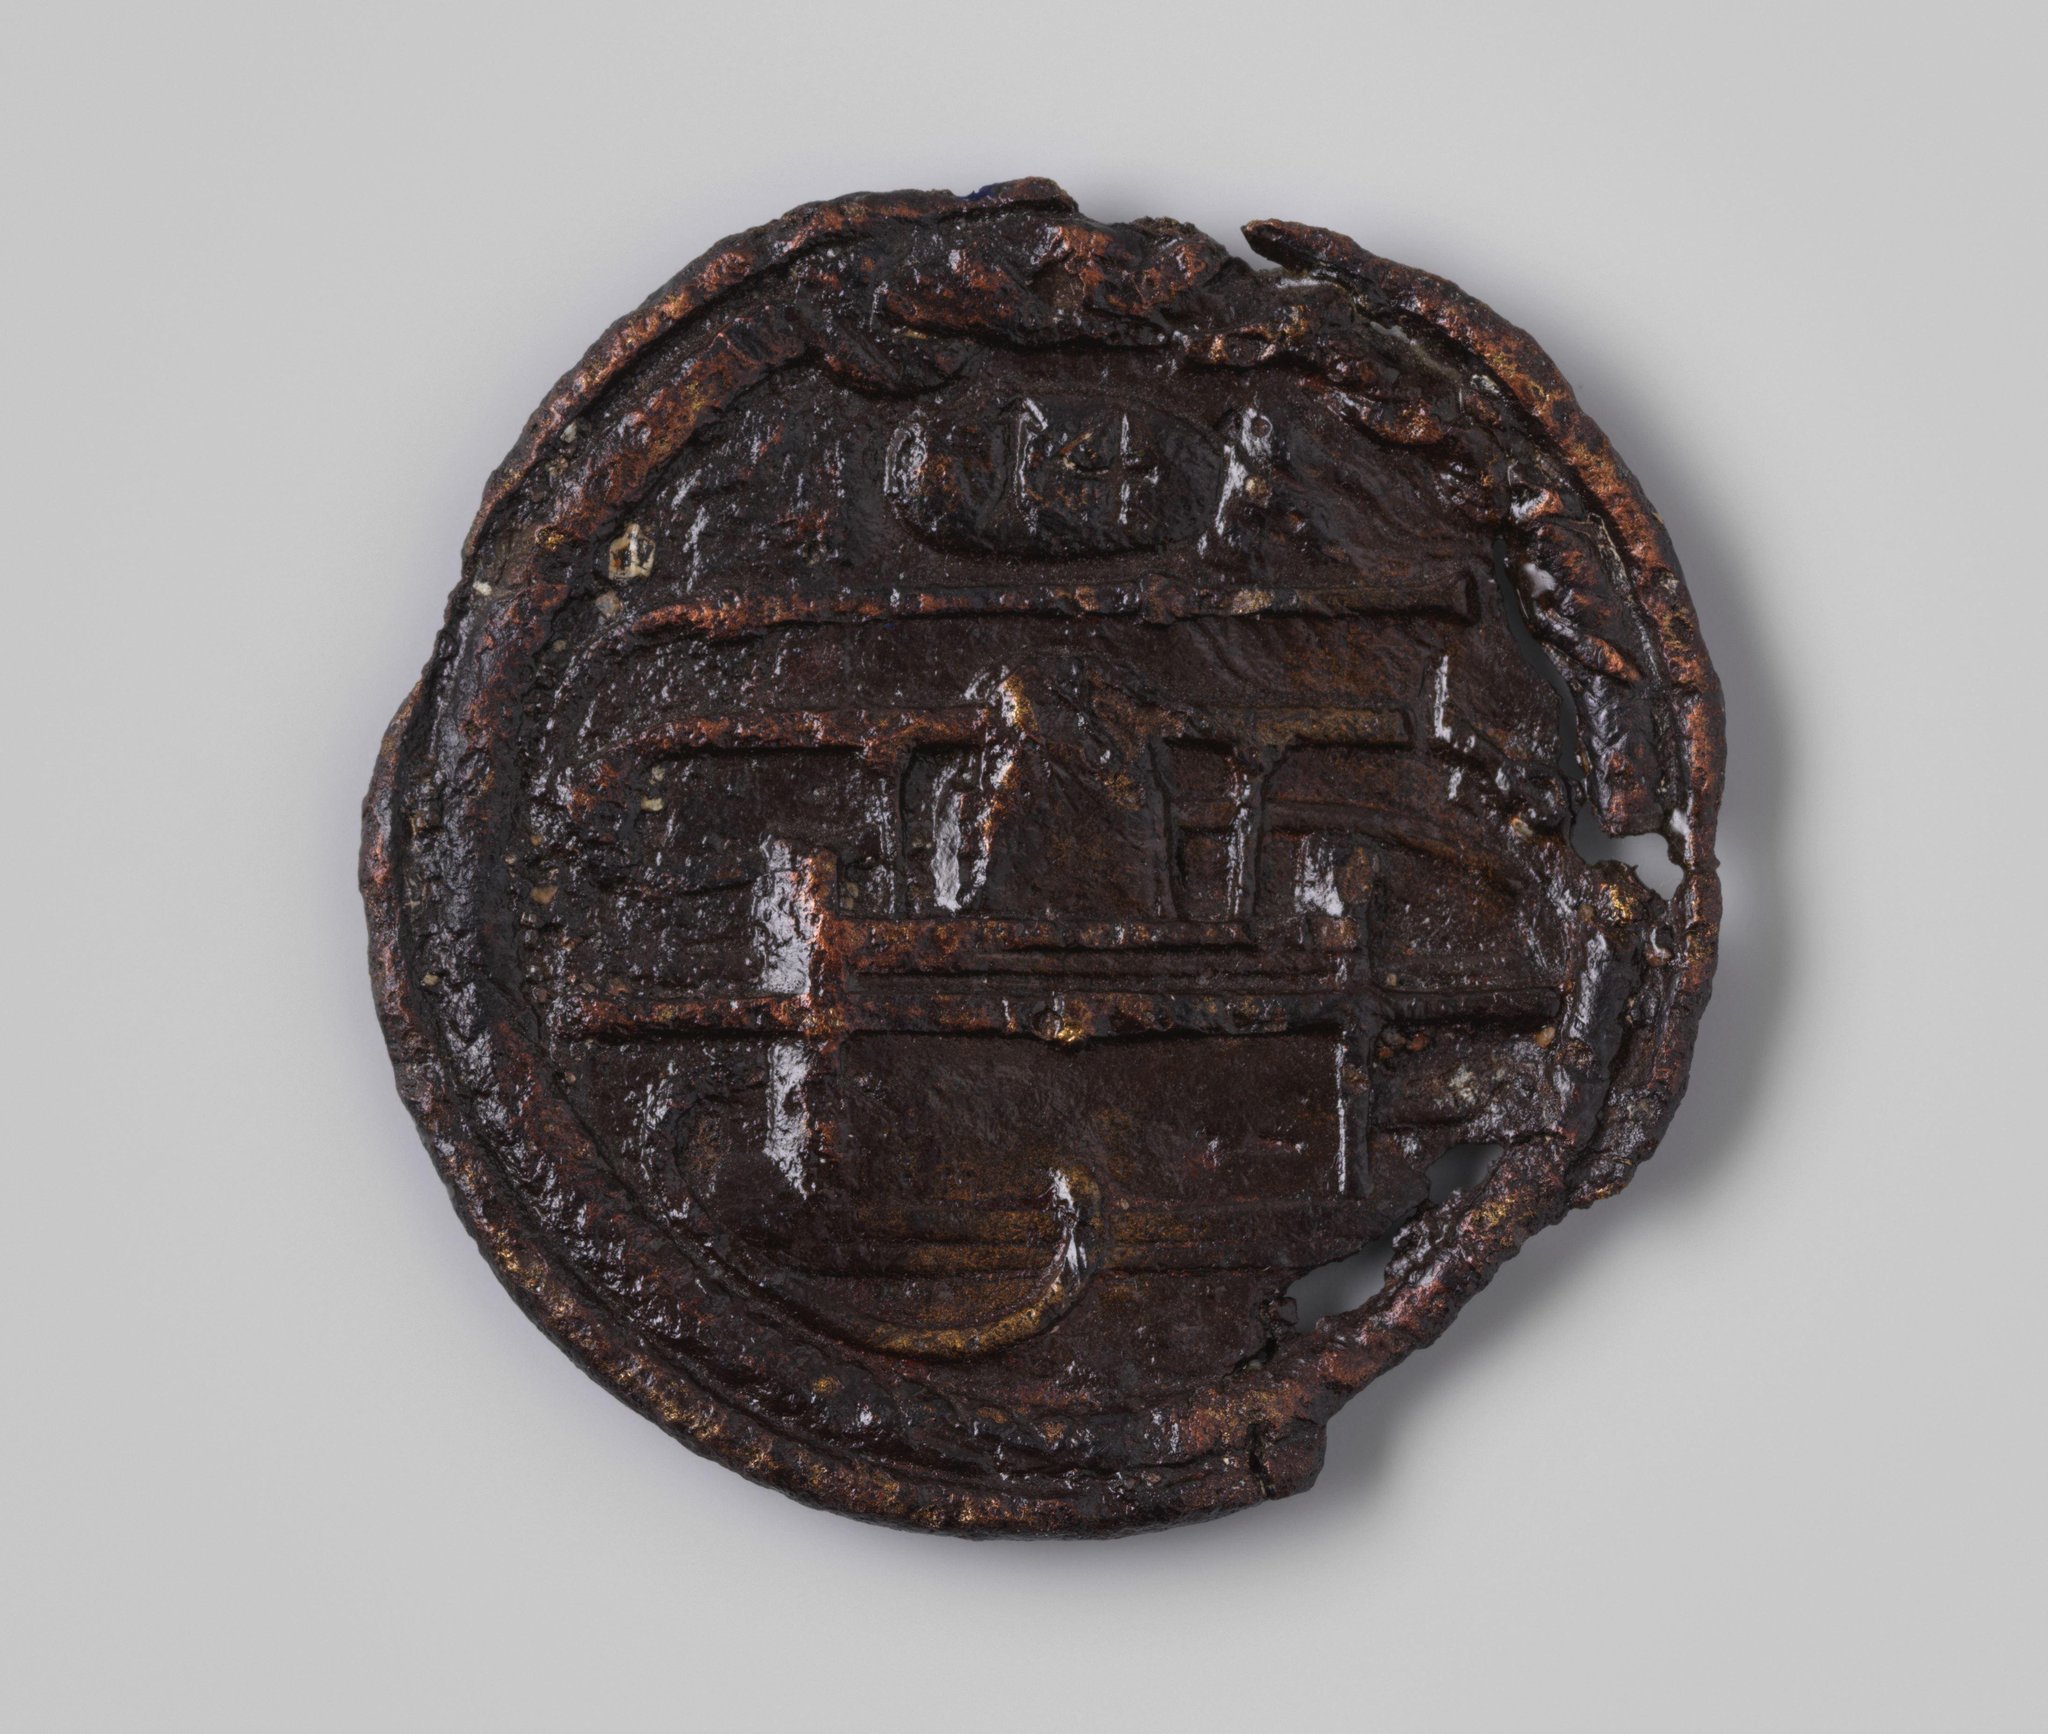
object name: fire engine medal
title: Medaillion of a fire brigade of Amsterdam from the wreck of the Dutch East India ship Hollandia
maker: Anonymous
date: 1700-1743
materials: copper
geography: netherlands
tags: verenigde oostindische compagnie, hollandia (schip), annet